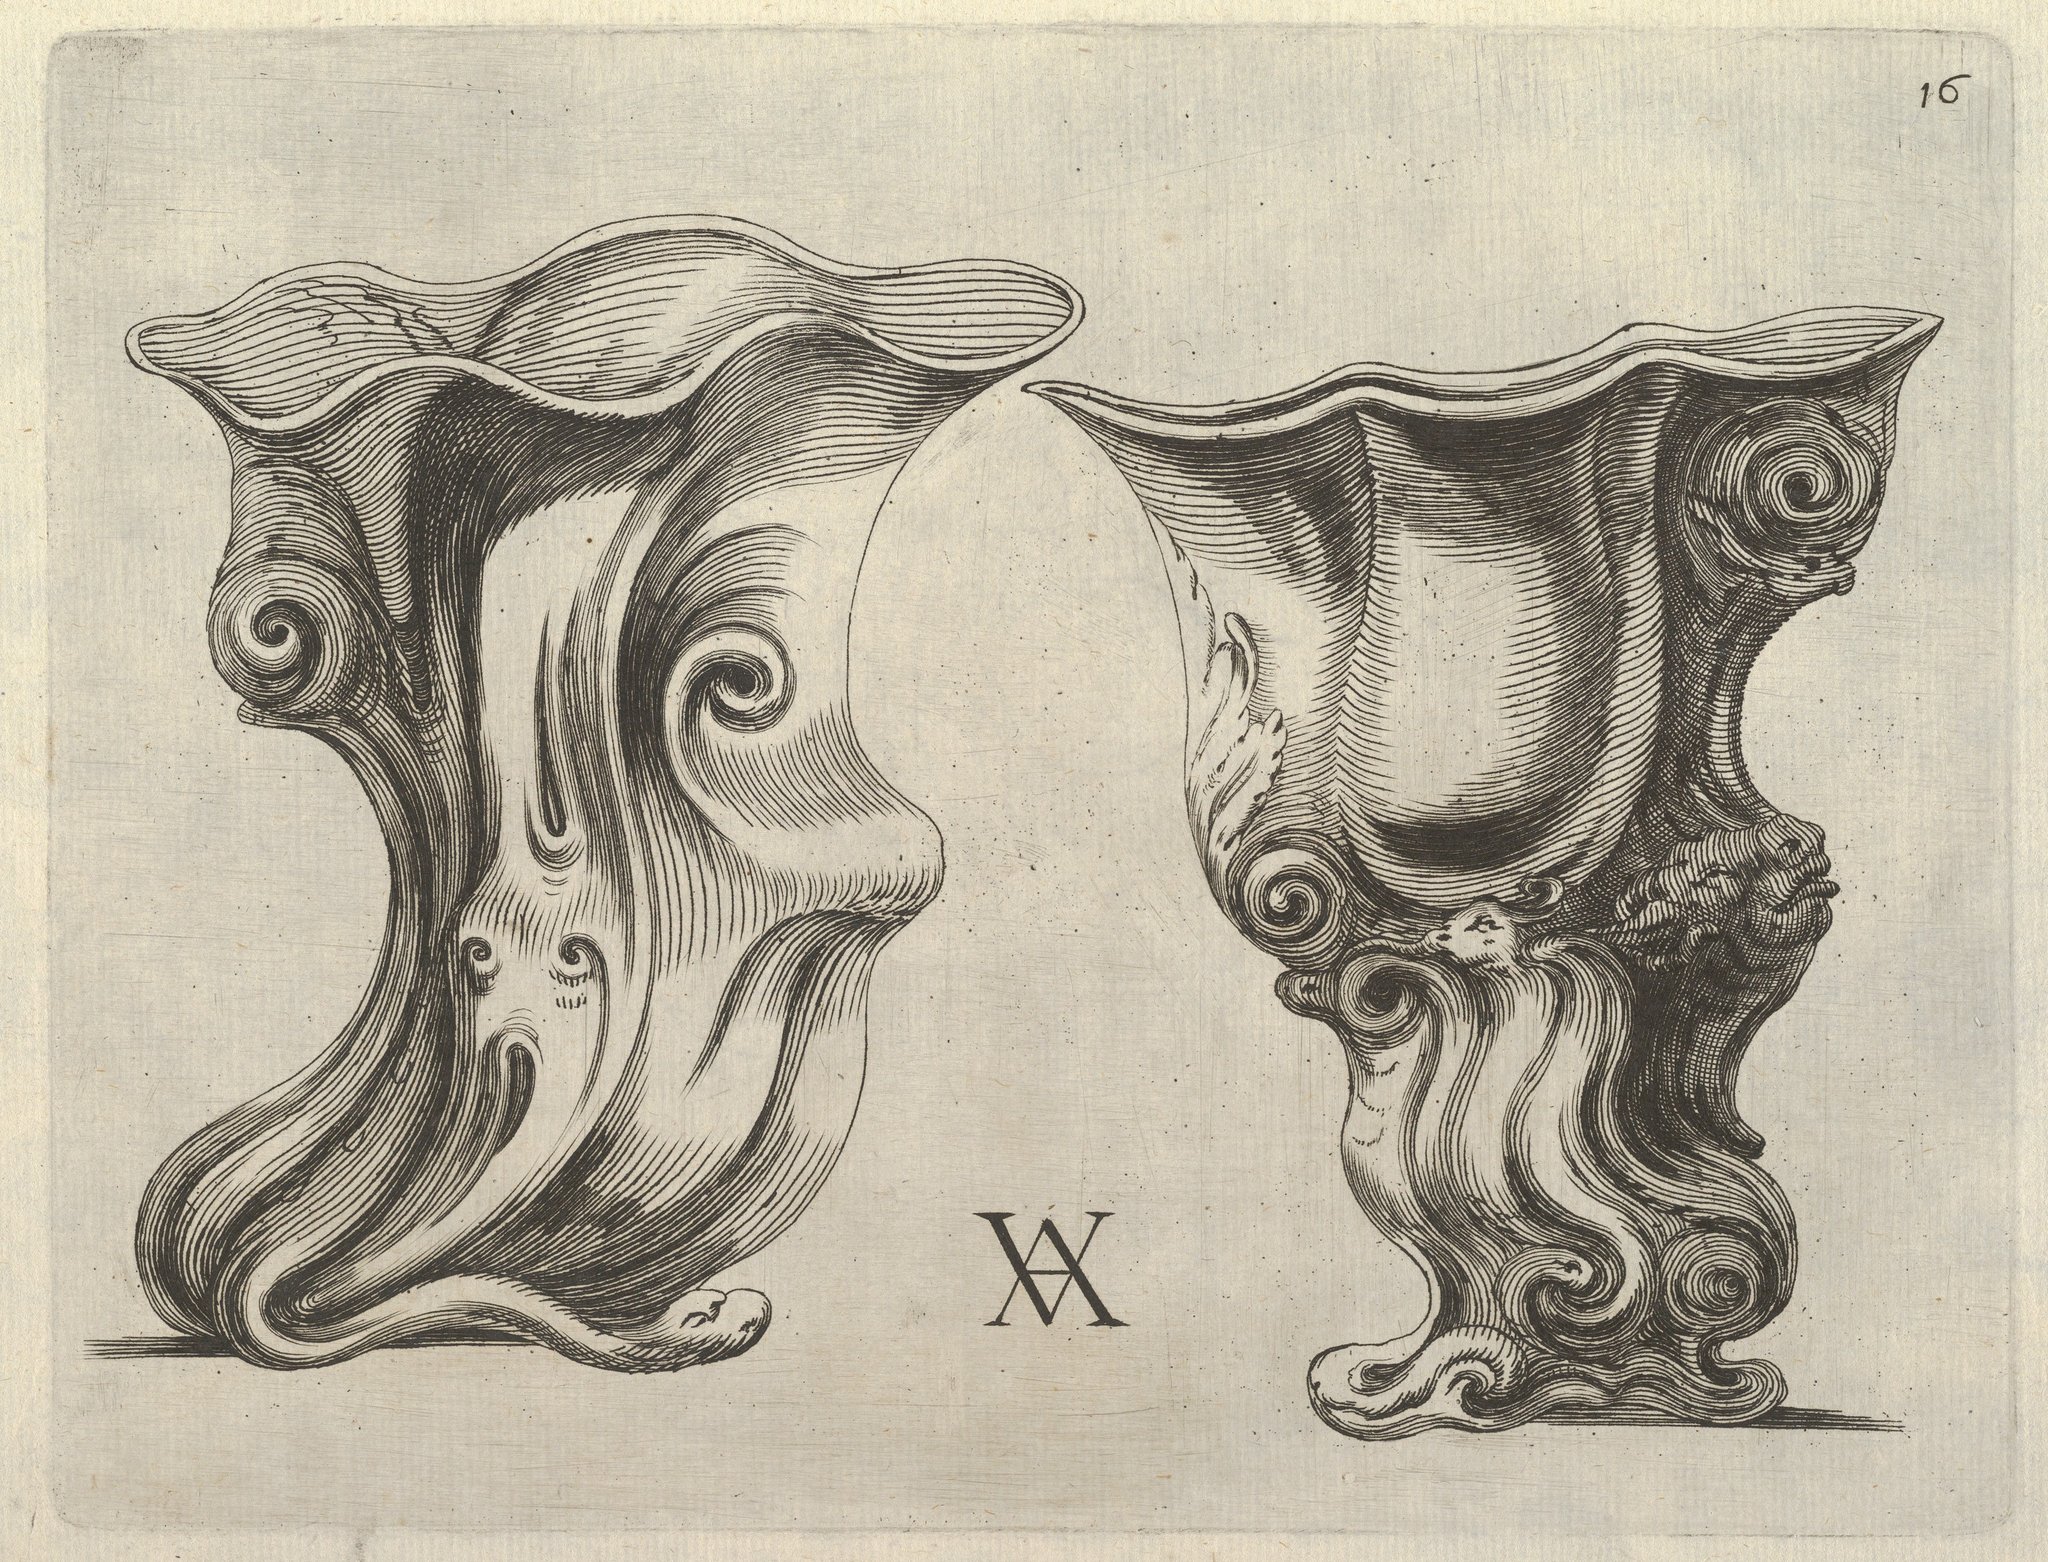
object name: album print ornament architecture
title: Plate 16, from "Modelli Artificiosi di Vasi diversi d'argento et altre Opere capriciozi (...), Parte prima"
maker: theodor van kessel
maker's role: artist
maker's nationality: dutch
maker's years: 1620-1660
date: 1646-1652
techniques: etching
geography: netherlands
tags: vases